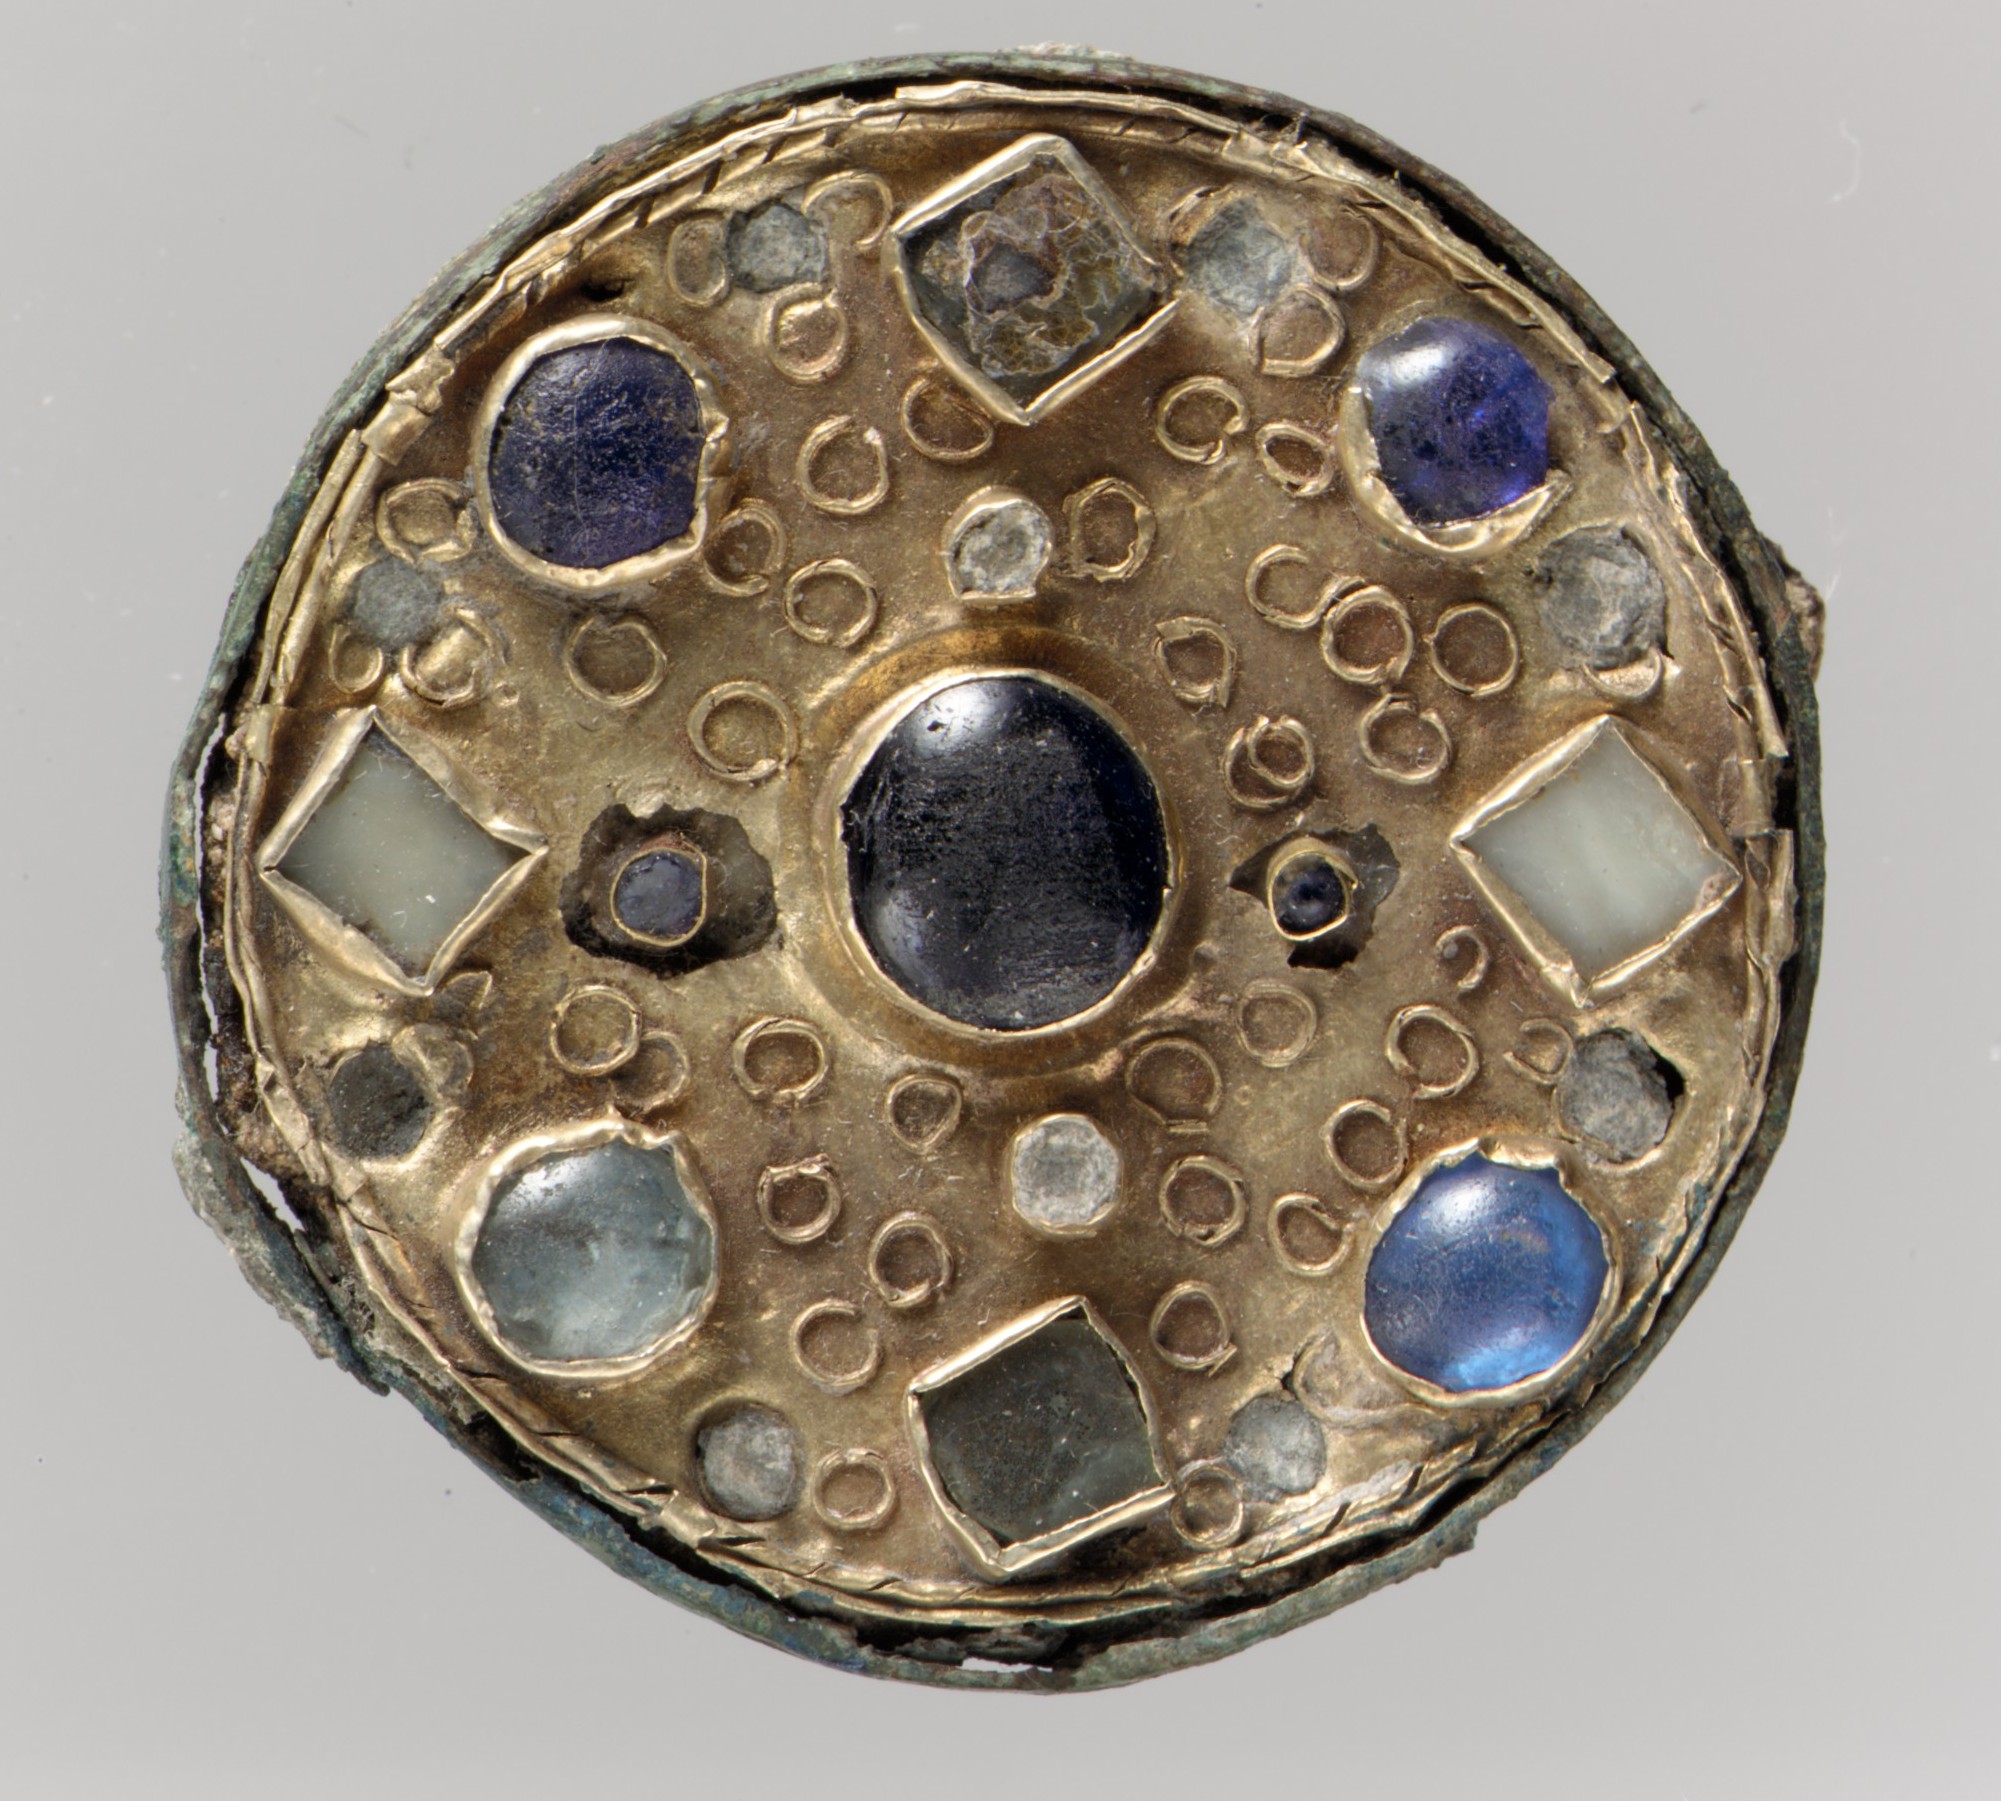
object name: brooch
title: Disk Brooch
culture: frankish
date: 567-633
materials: copper alloy, glass, gold, iron, paste